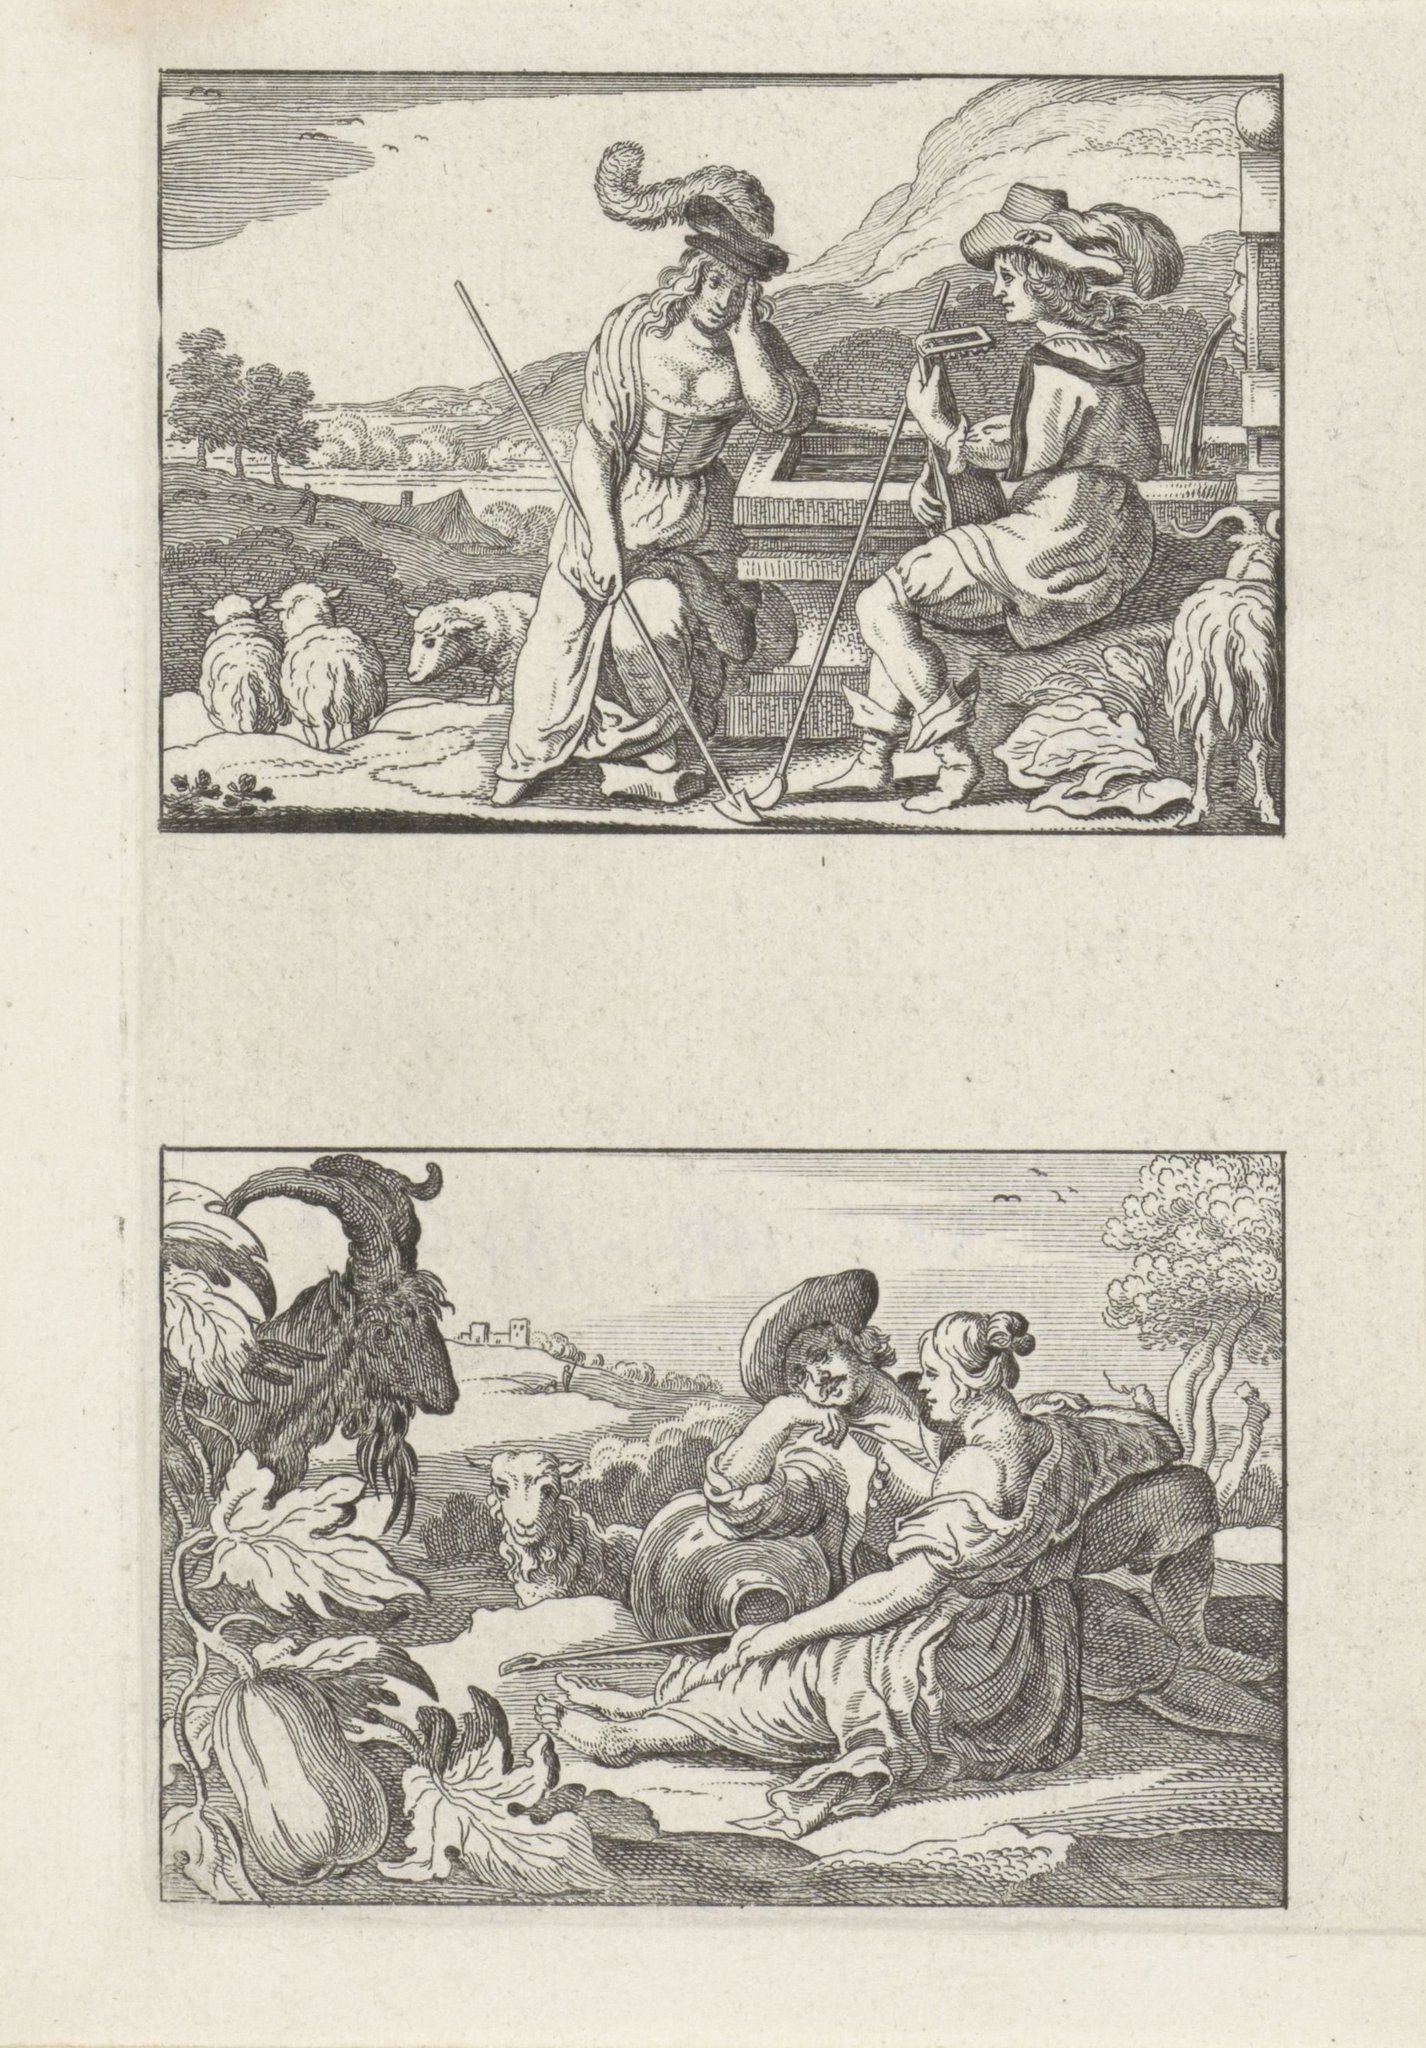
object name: popular print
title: Herders en herderinnen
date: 1633-1679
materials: paper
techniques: etching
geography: netherlands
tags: pastorals, arcadian scenes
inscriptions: collector's mark: Lugt 2228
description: Blad met 2 voorstellingen van herders en herderinnen in een landschap. Boven: een musicerende herder en een herderin bij een fontein. Onder: een herder en herderin rustend.